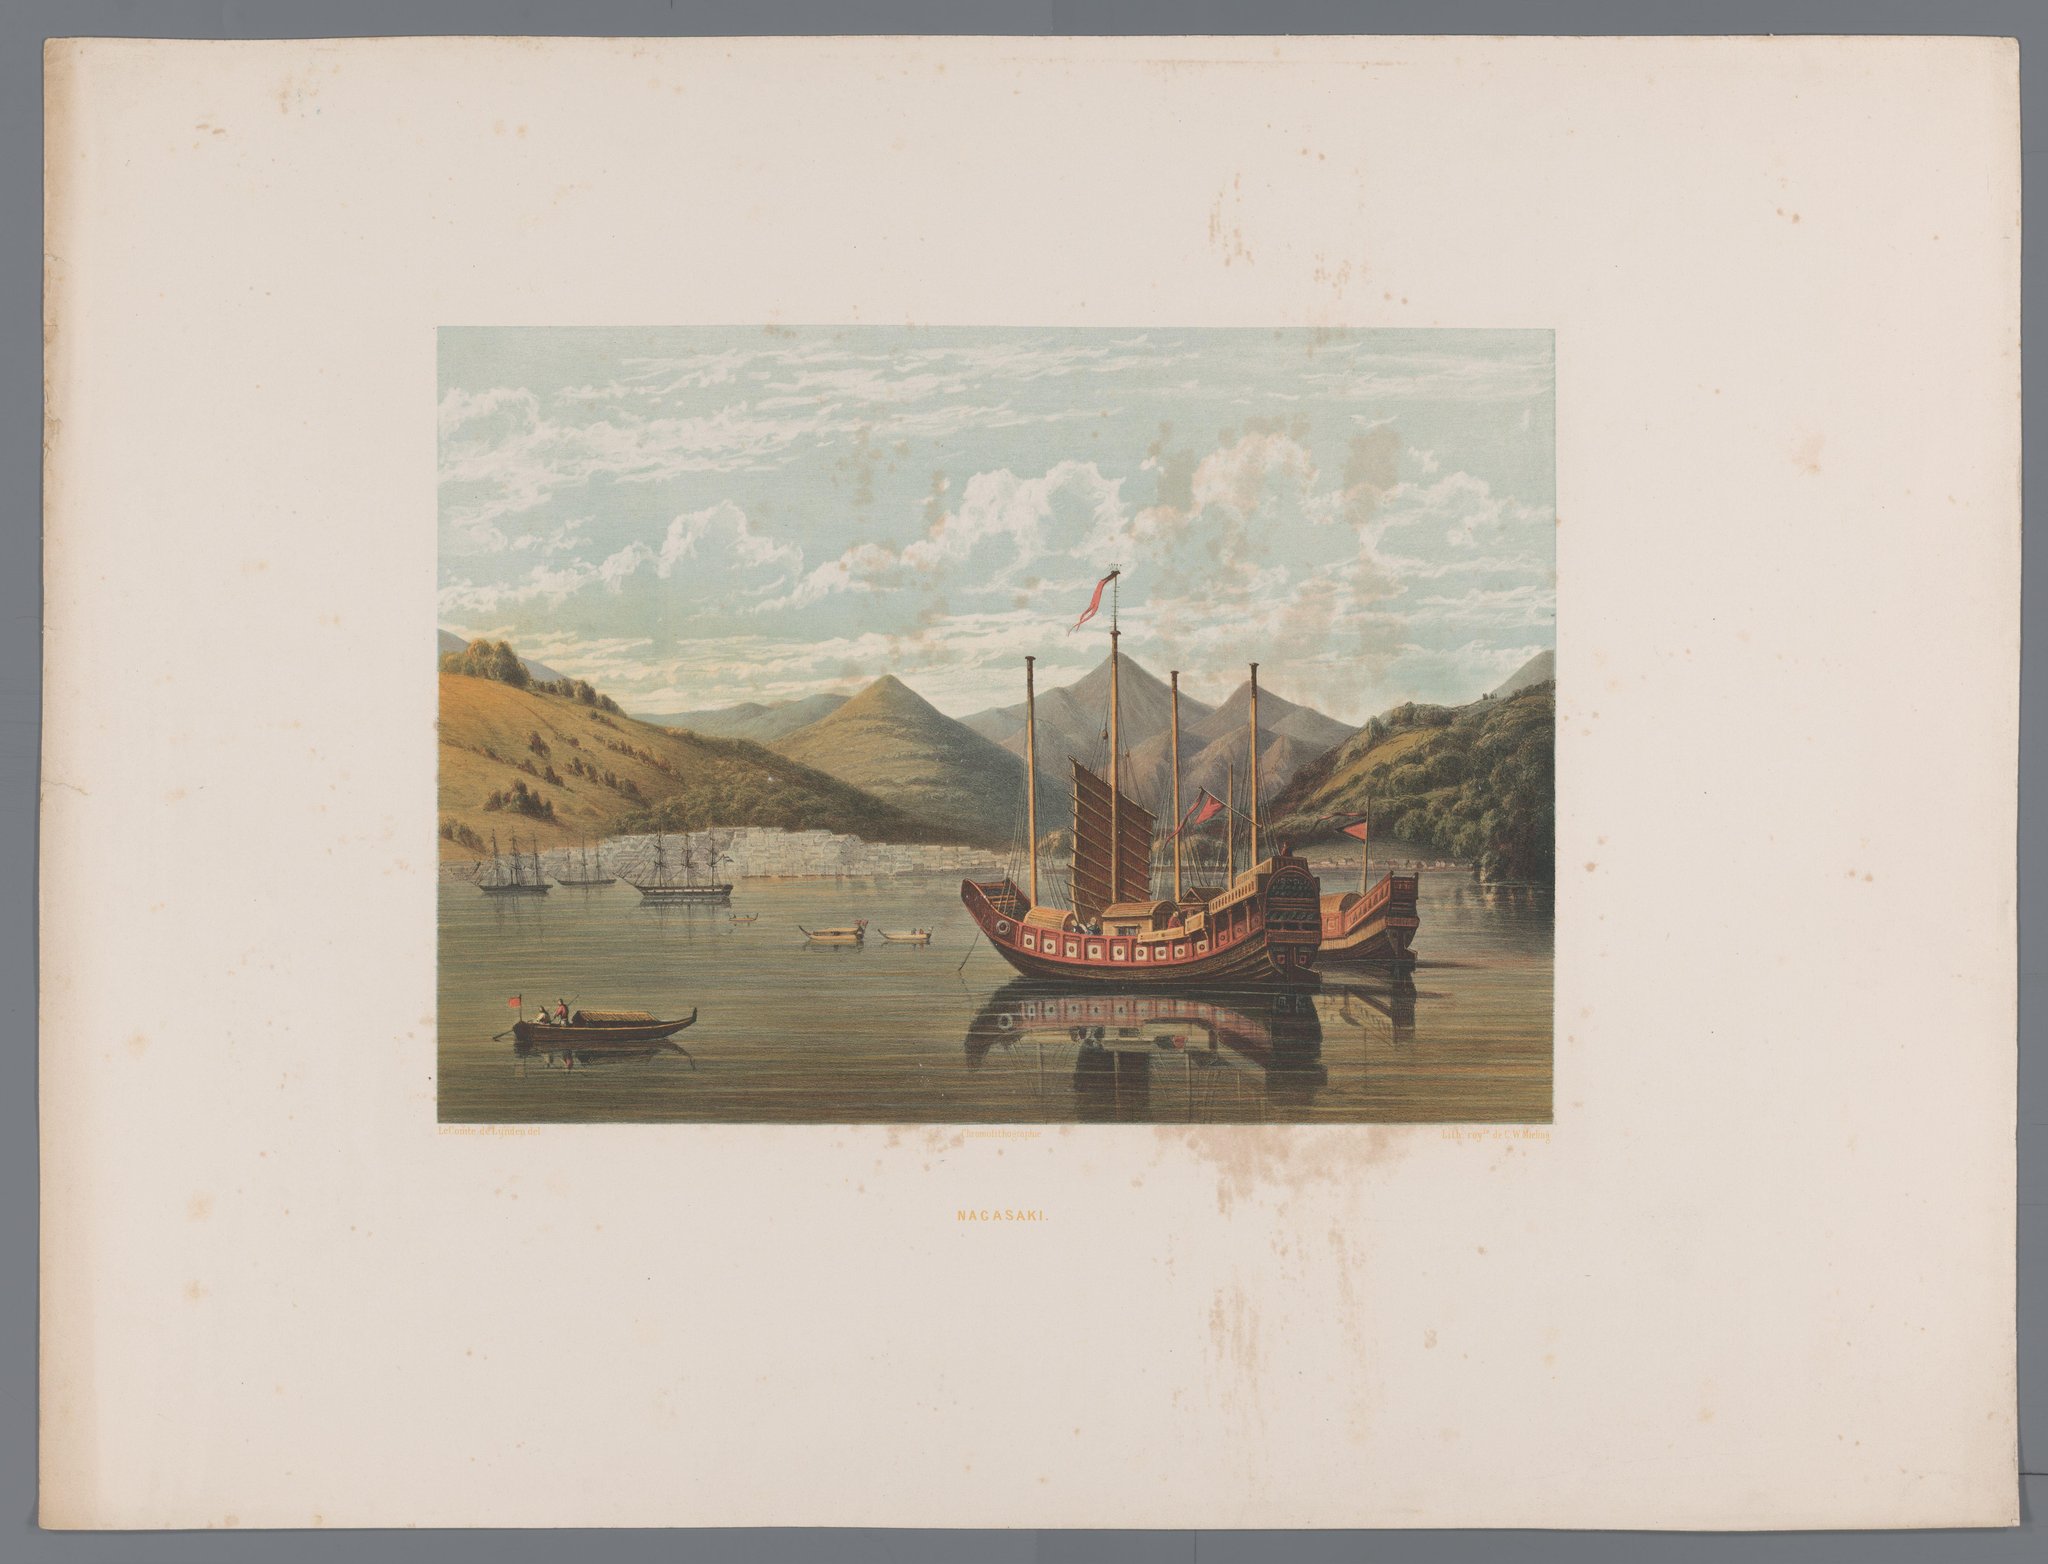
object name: print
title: Nagasaki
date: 1862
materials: paper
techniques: chromolithography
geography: the hague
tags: sailing-ship, sailing-boat, prospect of city, town panorama, silhouette of city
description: Gezicht op Nagasaki vanaf het water, met op de voorgrond Japanse schepen en links op de achtergrond Hollandse schepen.